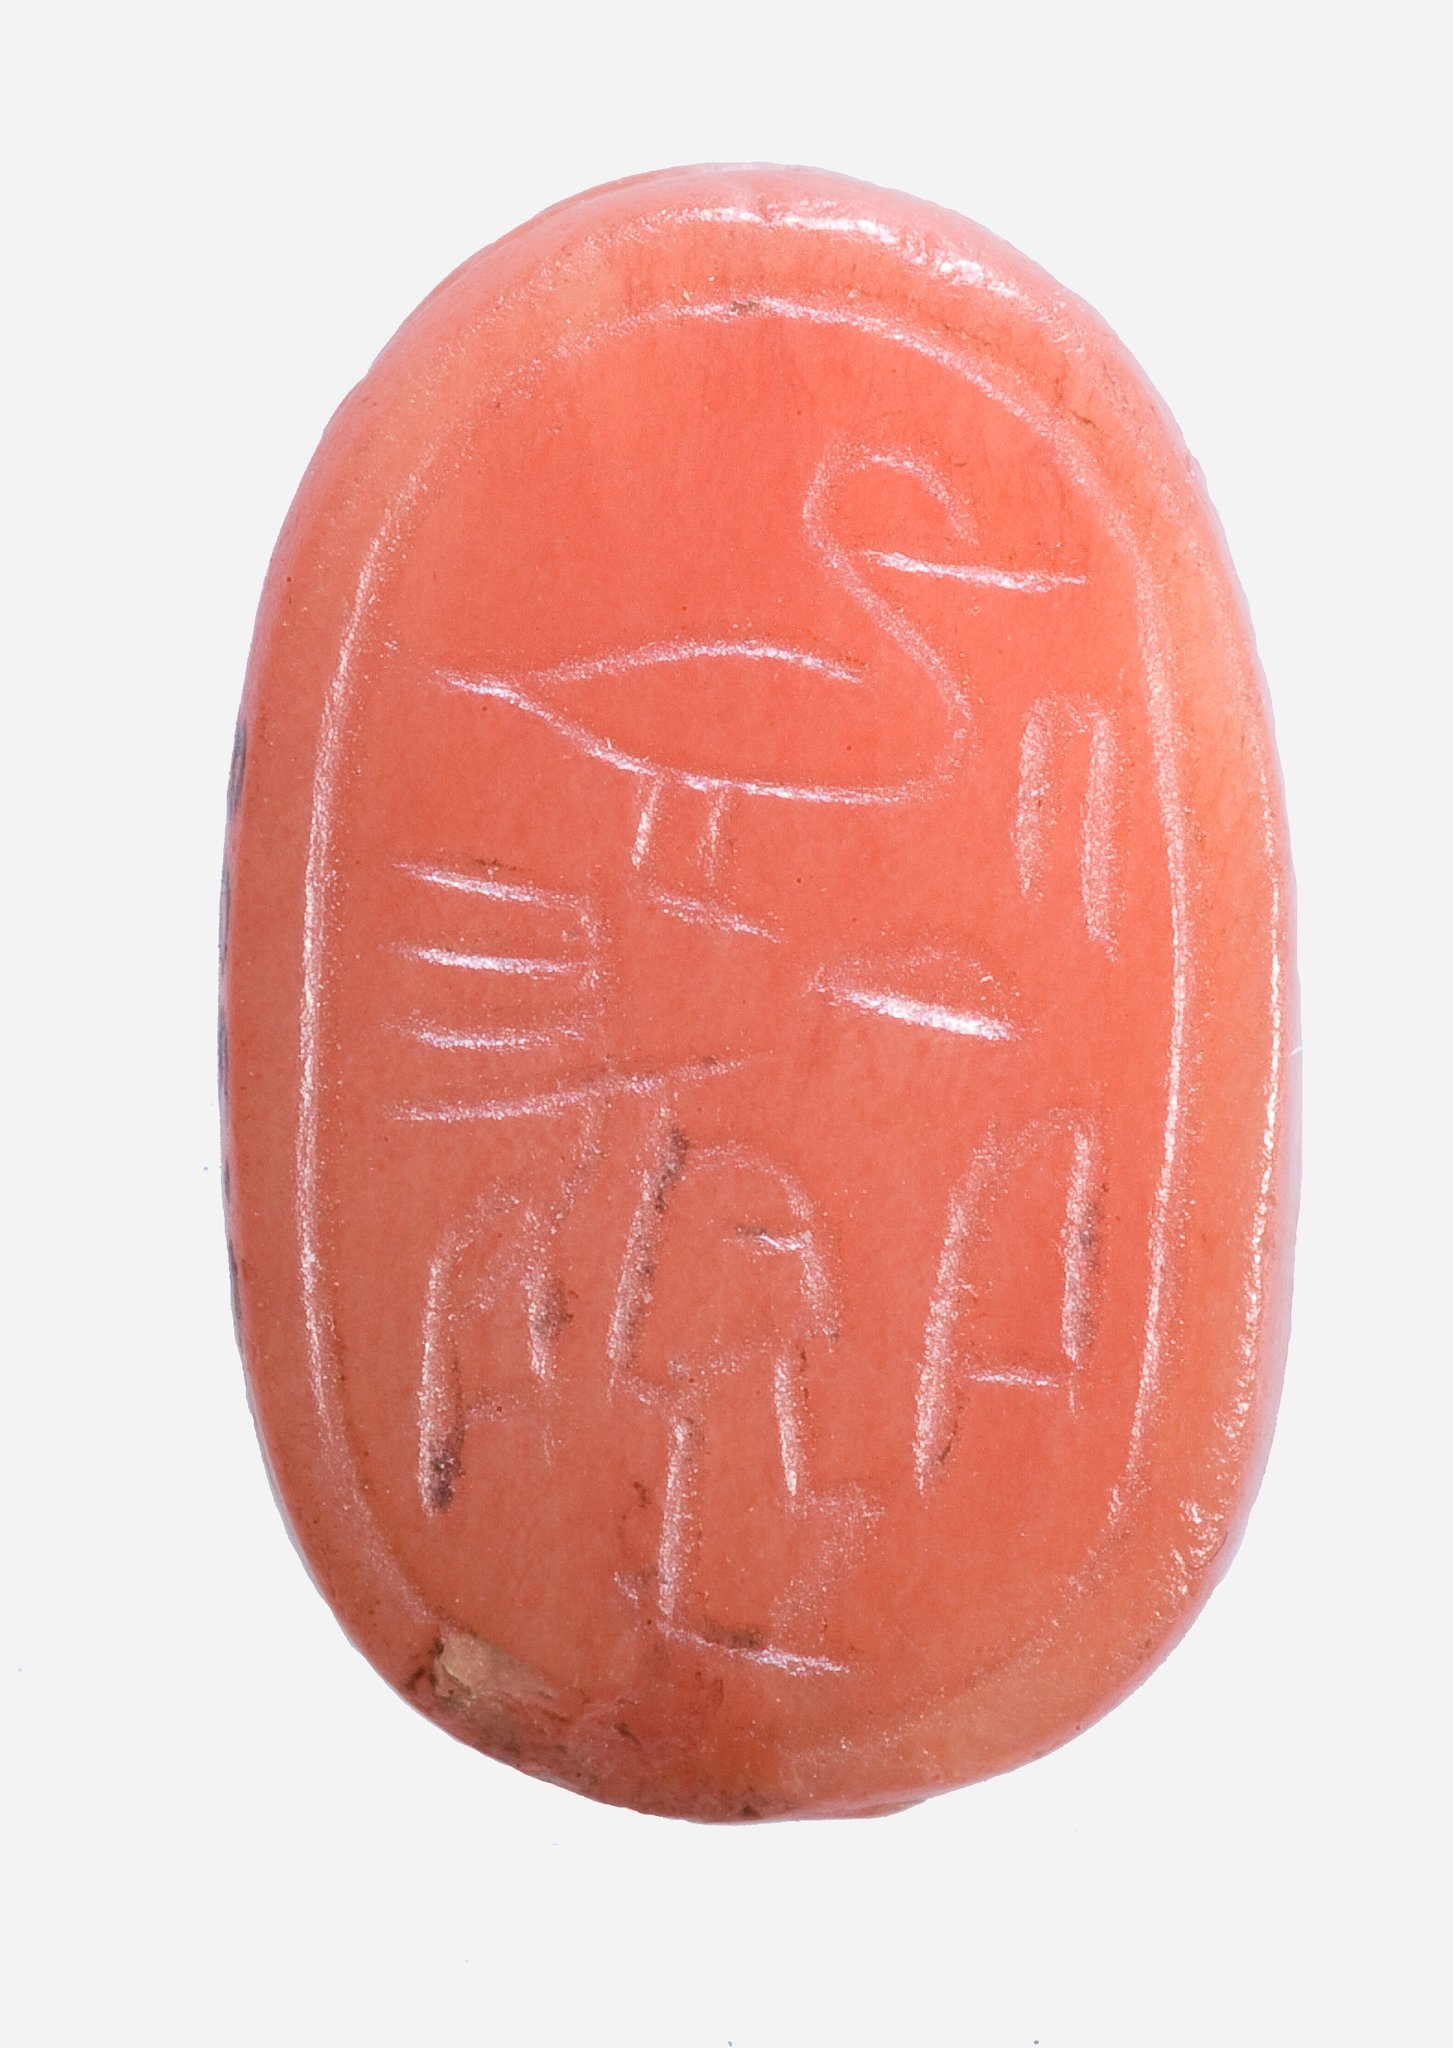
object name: scarab, private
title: Scarab Inscribed With a Private Name (?)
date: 1550-1458 BCE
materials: gemstone, jasper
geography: egypt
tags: hieroglyphs,scarabs